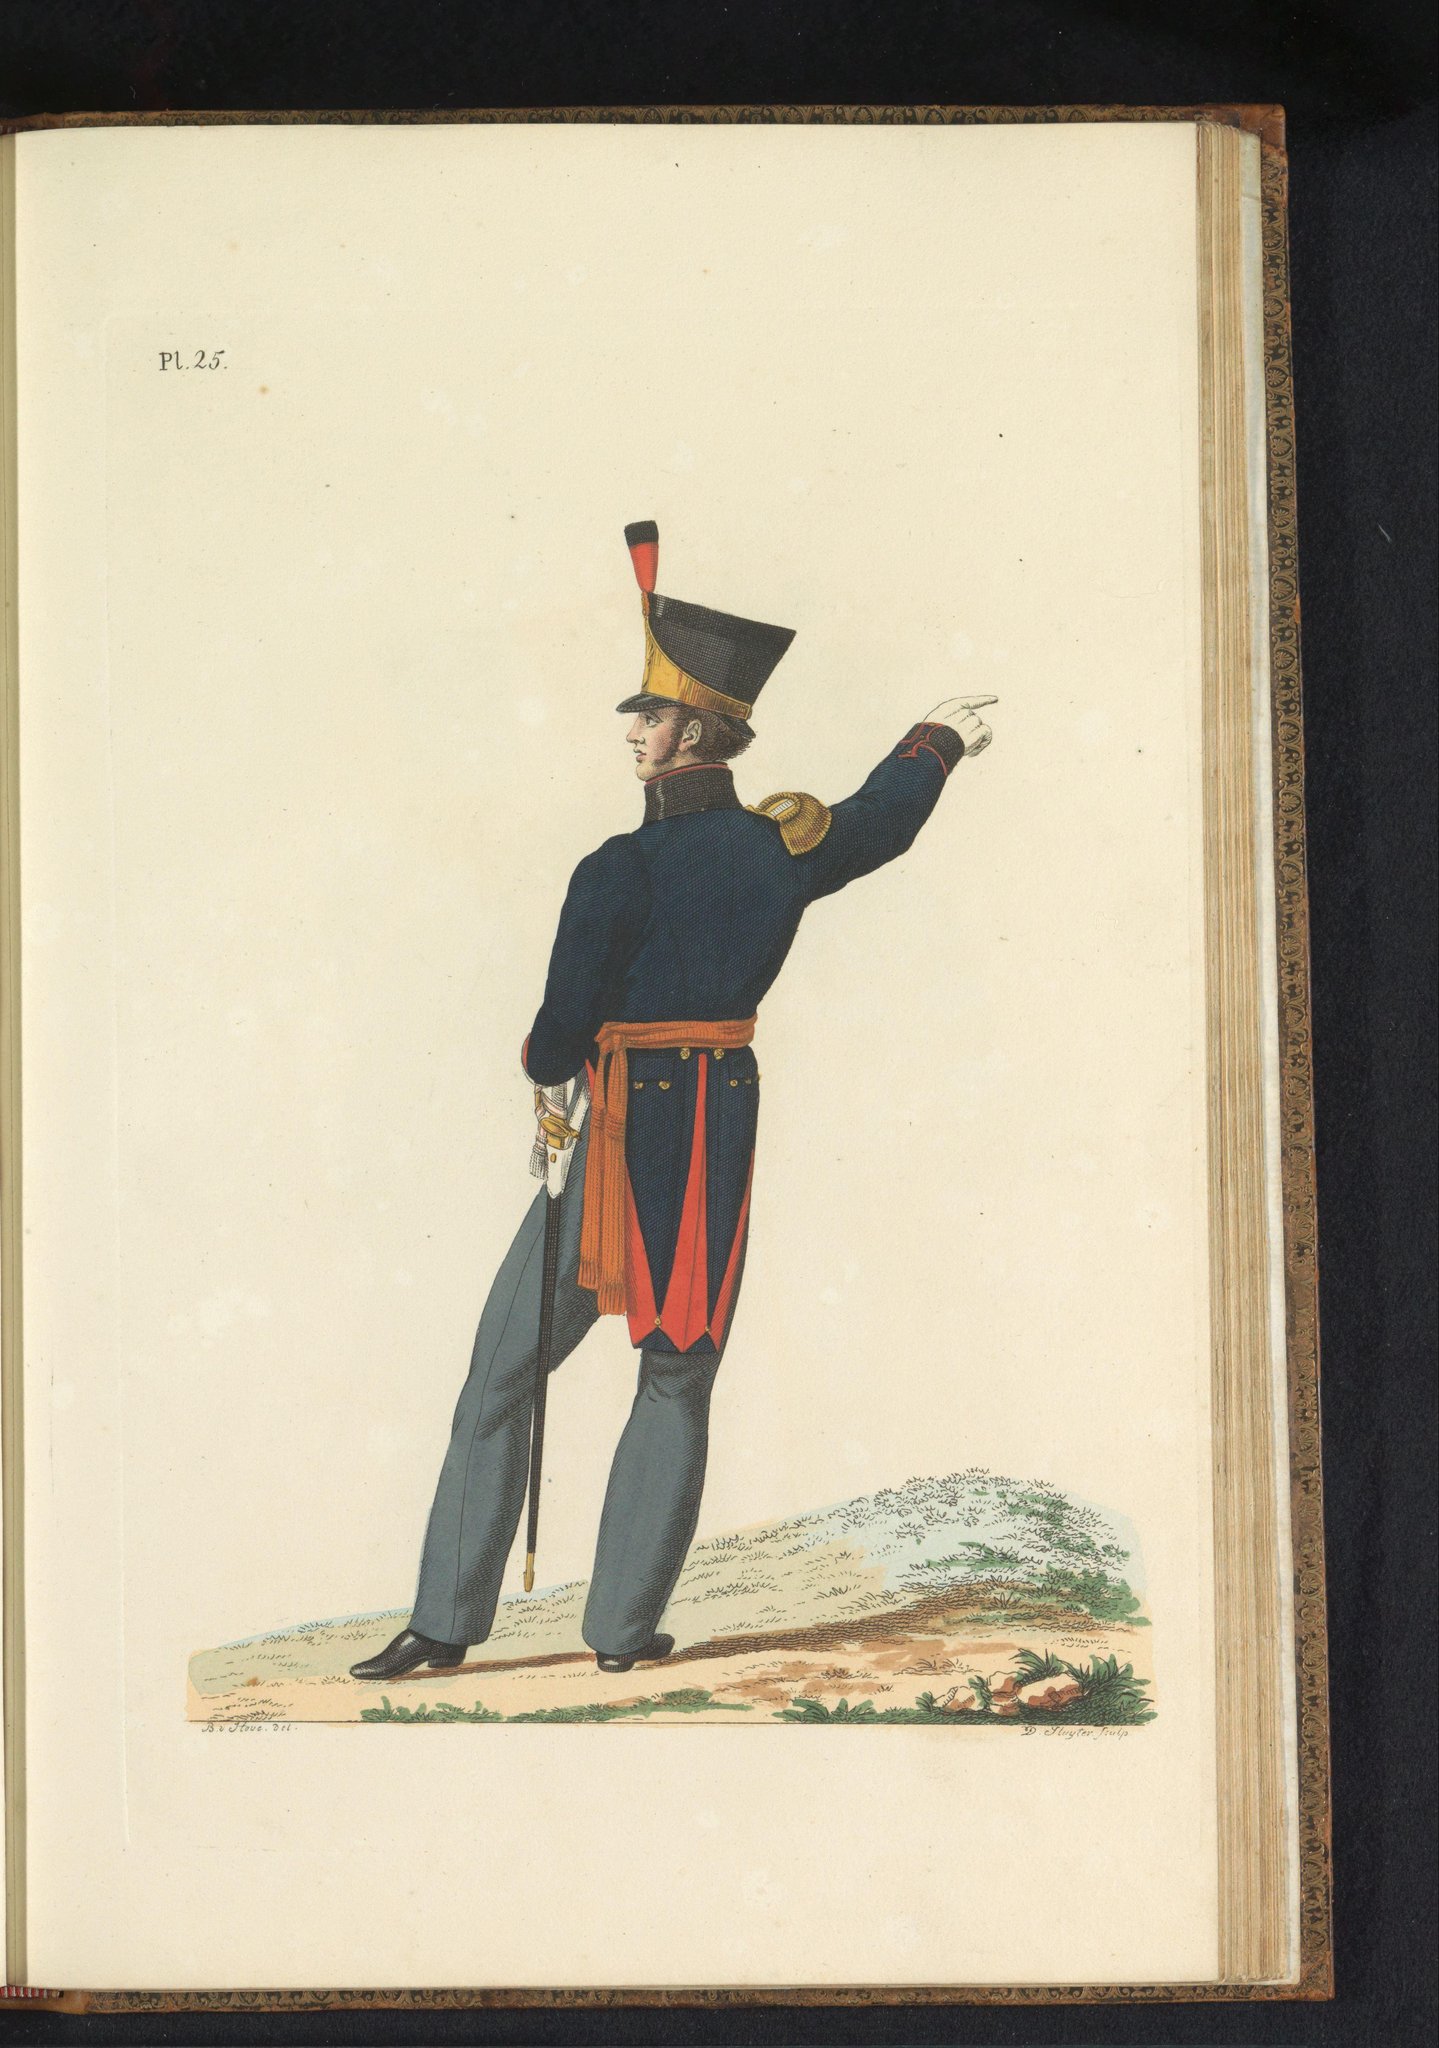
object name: print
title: Eerste Luitenant der Artillerie te voet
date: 1823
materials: paper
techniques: engraving, etching, hand coloring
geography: the hague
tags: (military) uniforms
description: Een Nederlandse eerste luitenant van de artillerie te voet. Plaat 25. Uniformvoorstelling in 'Beschrijving hoedanig de Koninklijke Nederlandsche troepen' van J.F. Teupken, 1823.